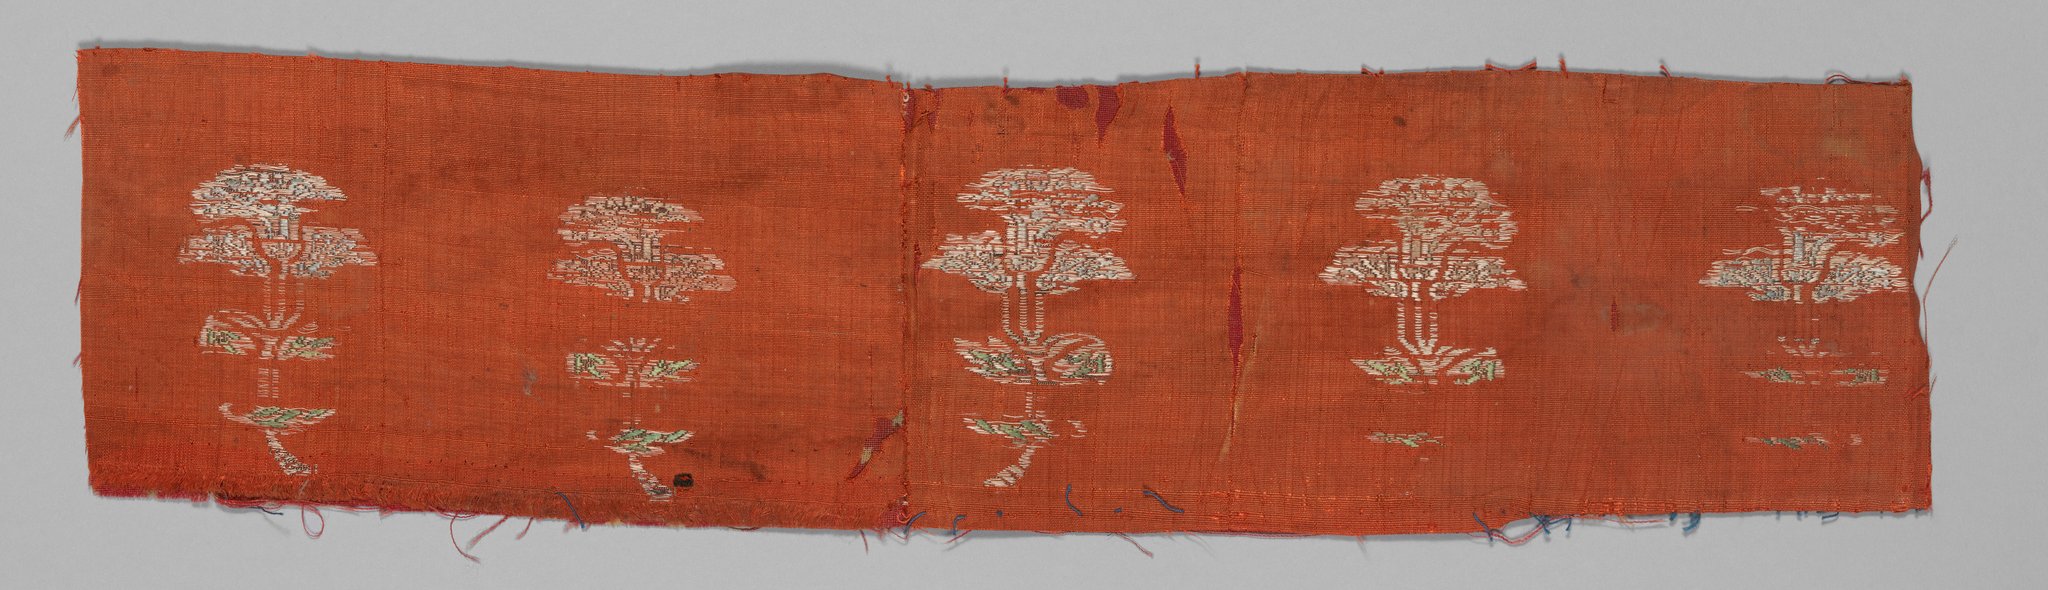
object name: textile fragment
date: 1601-1700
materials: metal thread, silk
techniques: brocade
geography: iran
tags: flowers